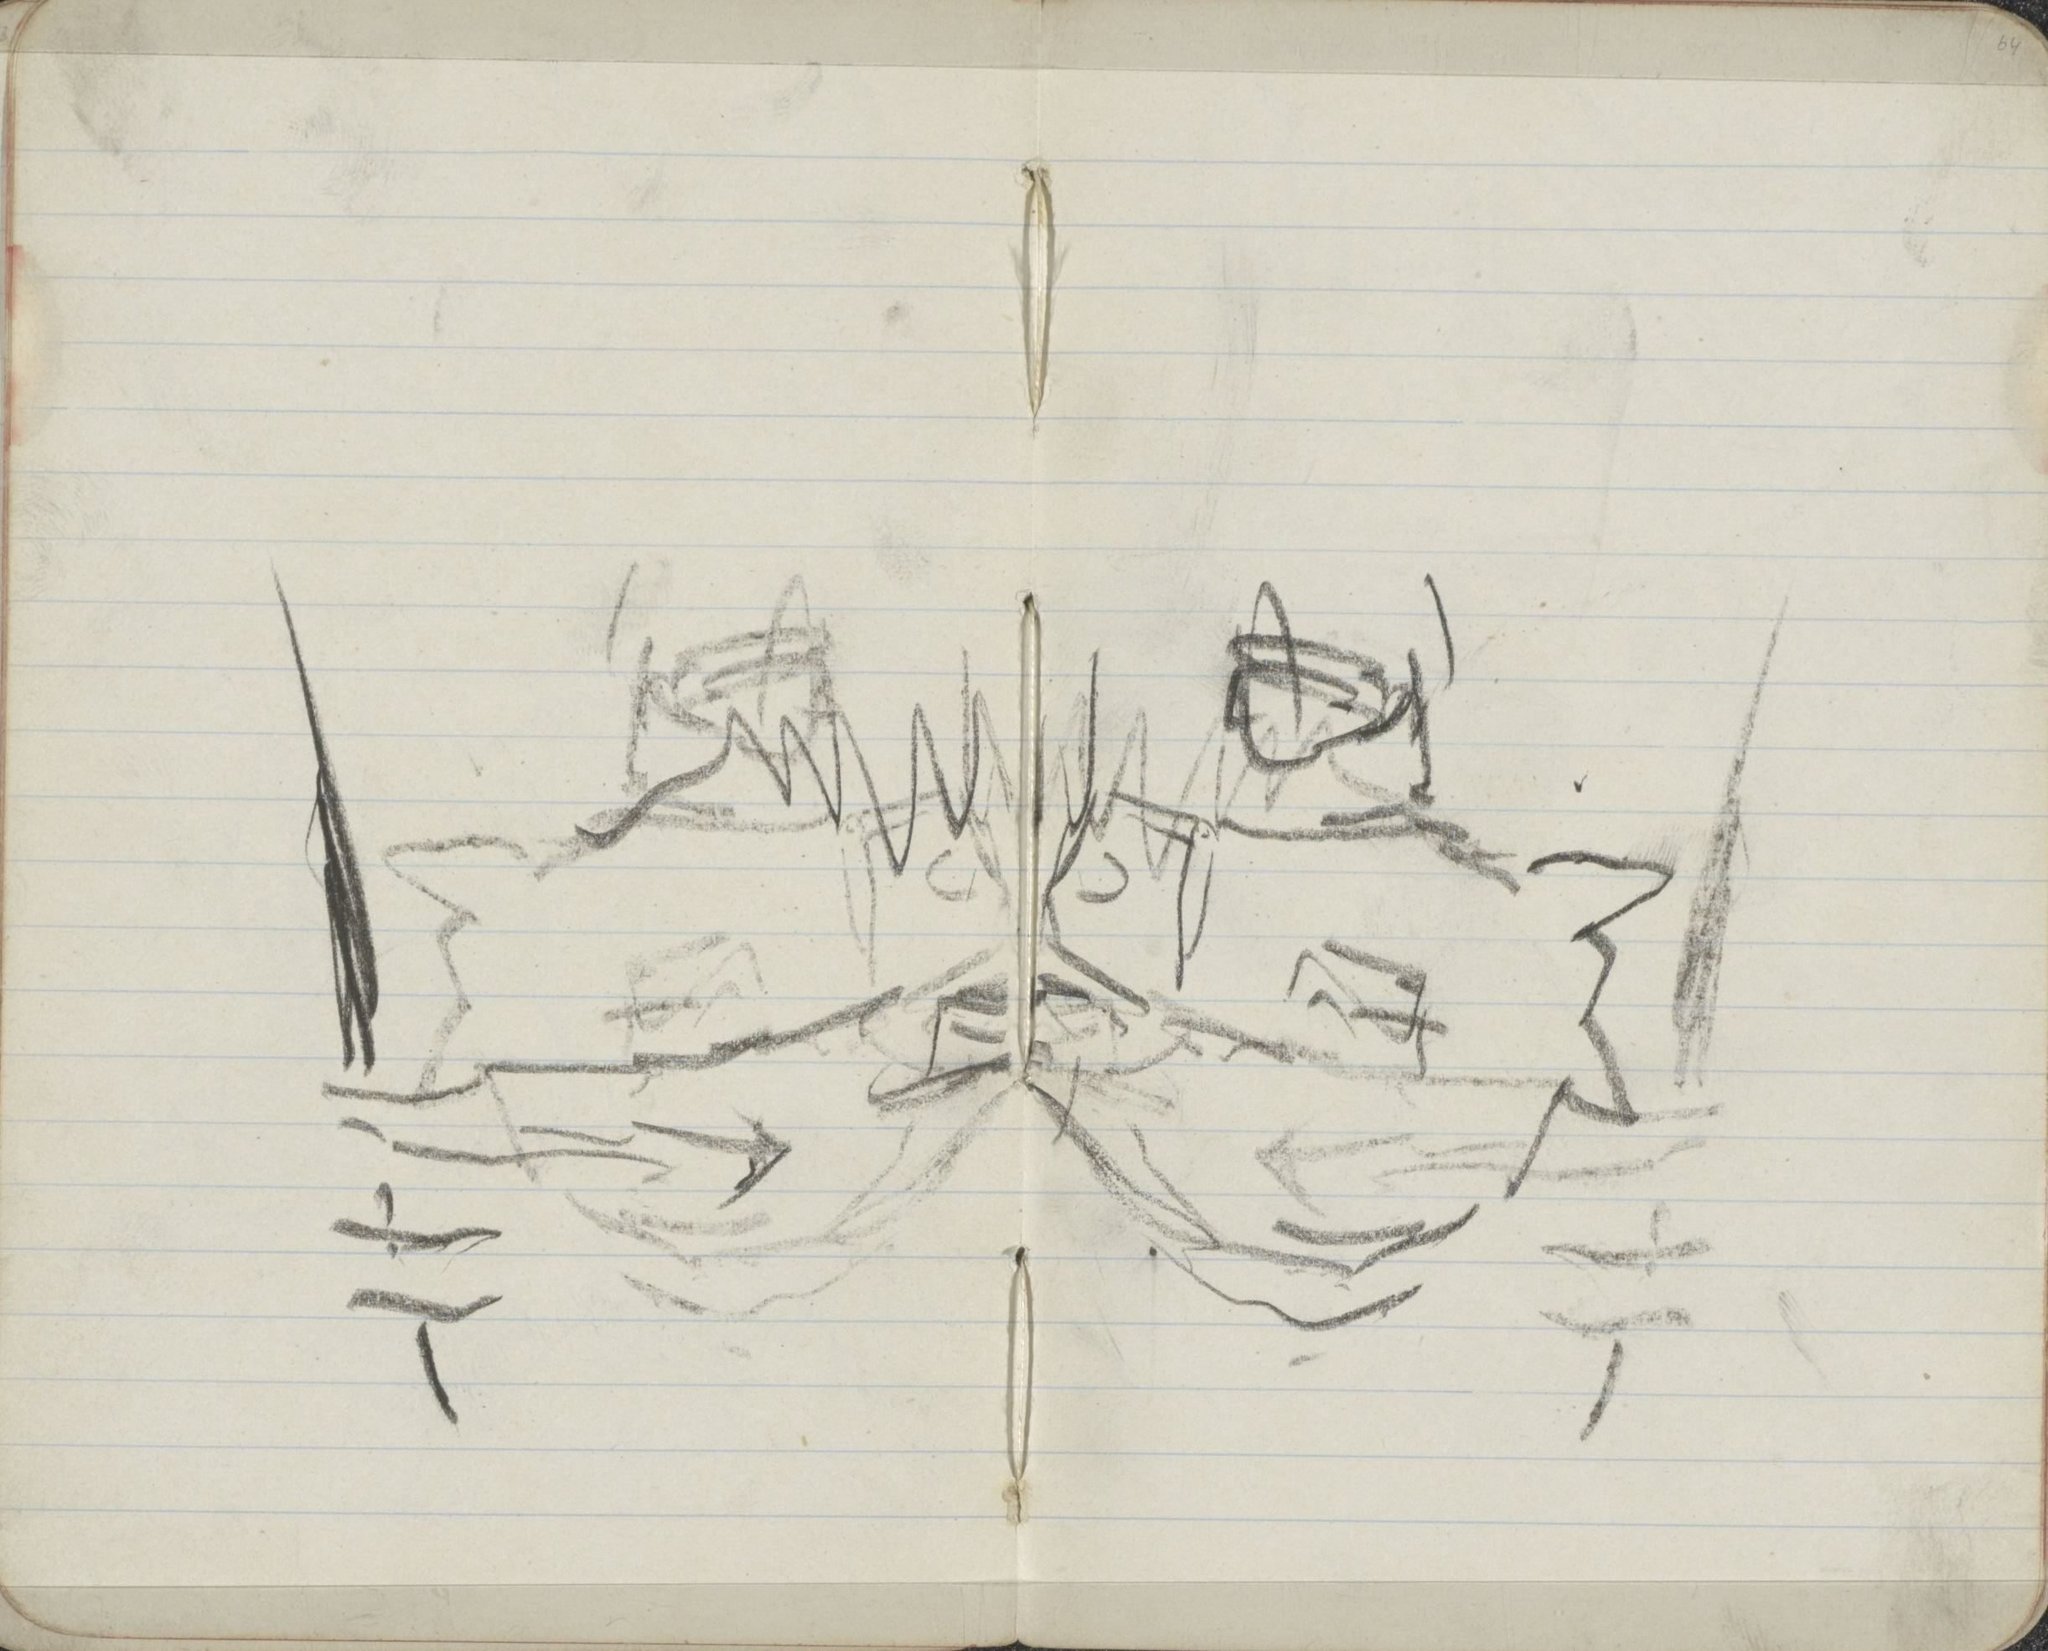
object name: sketchbook leaf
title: Trampaard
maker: george hendrik breitner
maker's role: draughtsman, painter, print maker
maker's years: 1857-1923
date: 1893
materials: chalk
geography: amsterdam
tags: horse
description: Pagina 63 en pagina 64 uit een schetsboek met 38 bladen.